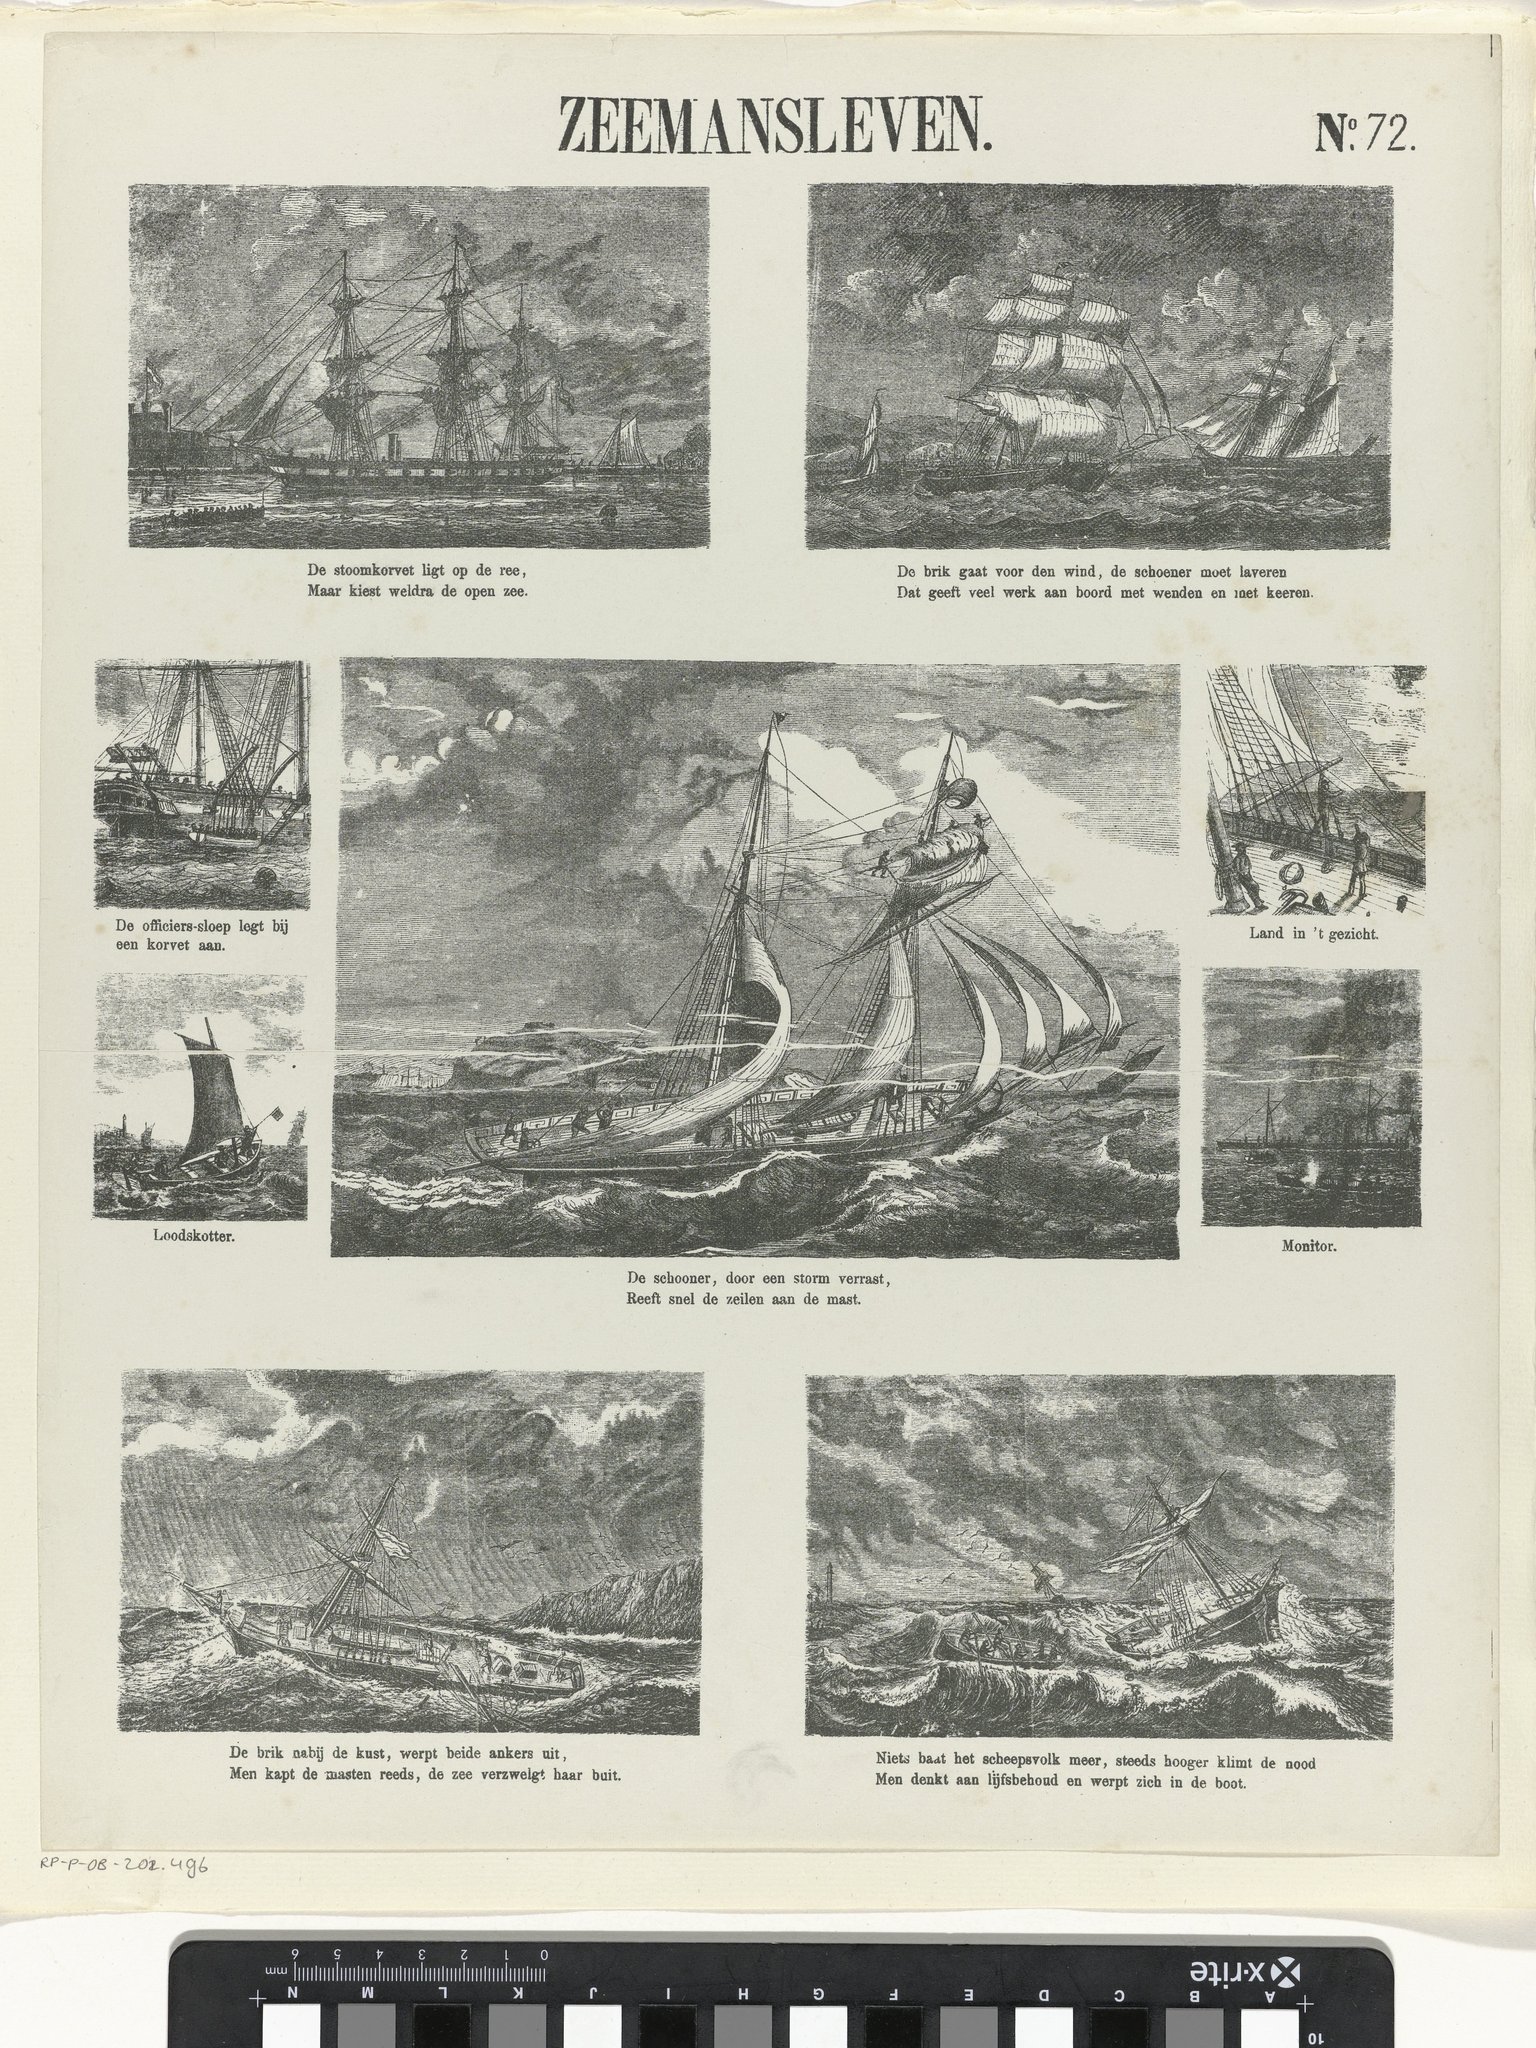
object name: popular print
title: Zeemansleven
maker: Anonymous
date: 1878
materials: paper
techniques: letterpress printing, lithograph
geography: amsterdam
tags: shipwreck, ships (in general)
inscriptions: collector's mark: Lugt 2760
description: Blad met 9 voorstellingen van verschillende scheepstypen en een scheepsramp. Onder elke afbeelding een onderschrift. Genummerd rechtsboven: No. 72.